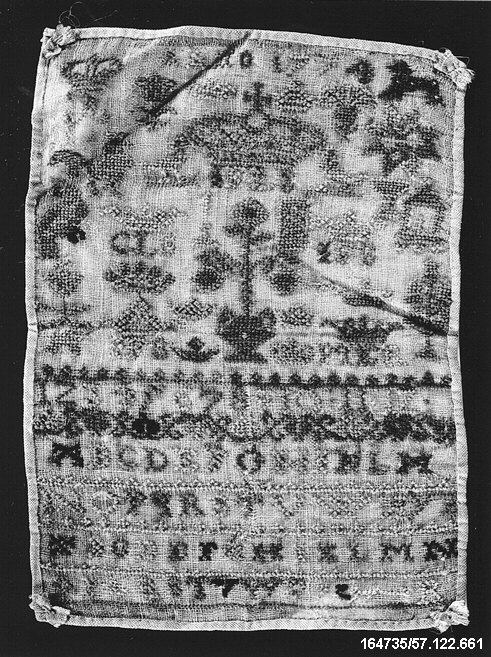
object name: sampler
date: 1774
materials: canvas, linen, silk, wool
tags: birds,flowers